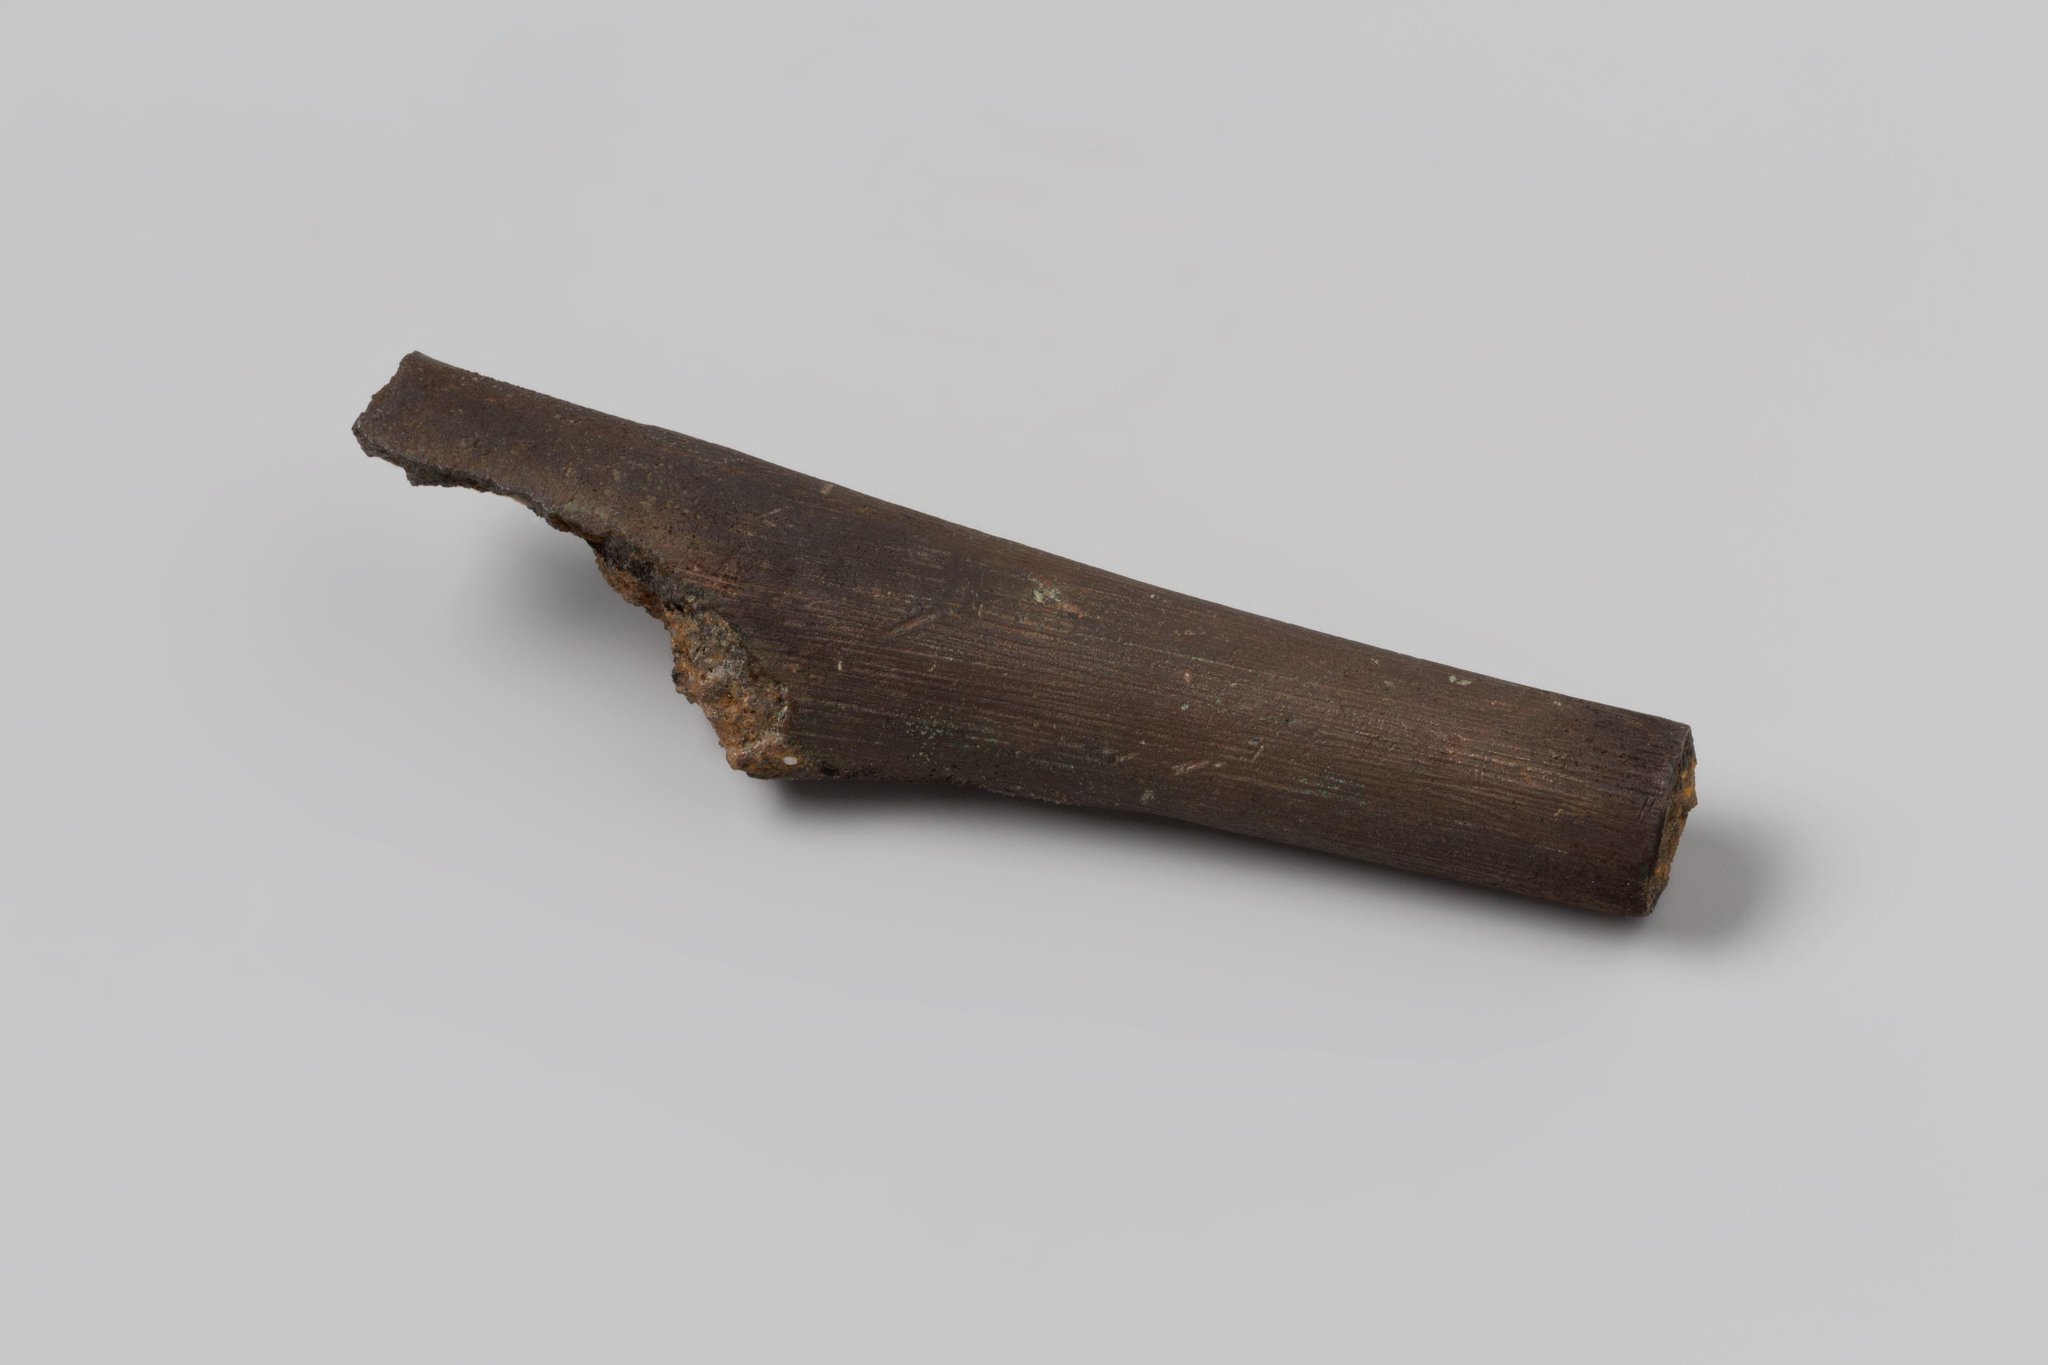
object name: tap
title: Fragment kraan uit het wrak van de Oost-Indiëvaarder Hollandia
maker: Anonymous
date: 1700-1743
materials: copper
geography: netherlands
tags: verenigde oostindische compagnie, hollandia (schip), annet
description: Tap, part of tap; fragm, end, id. NG 1979-521H.